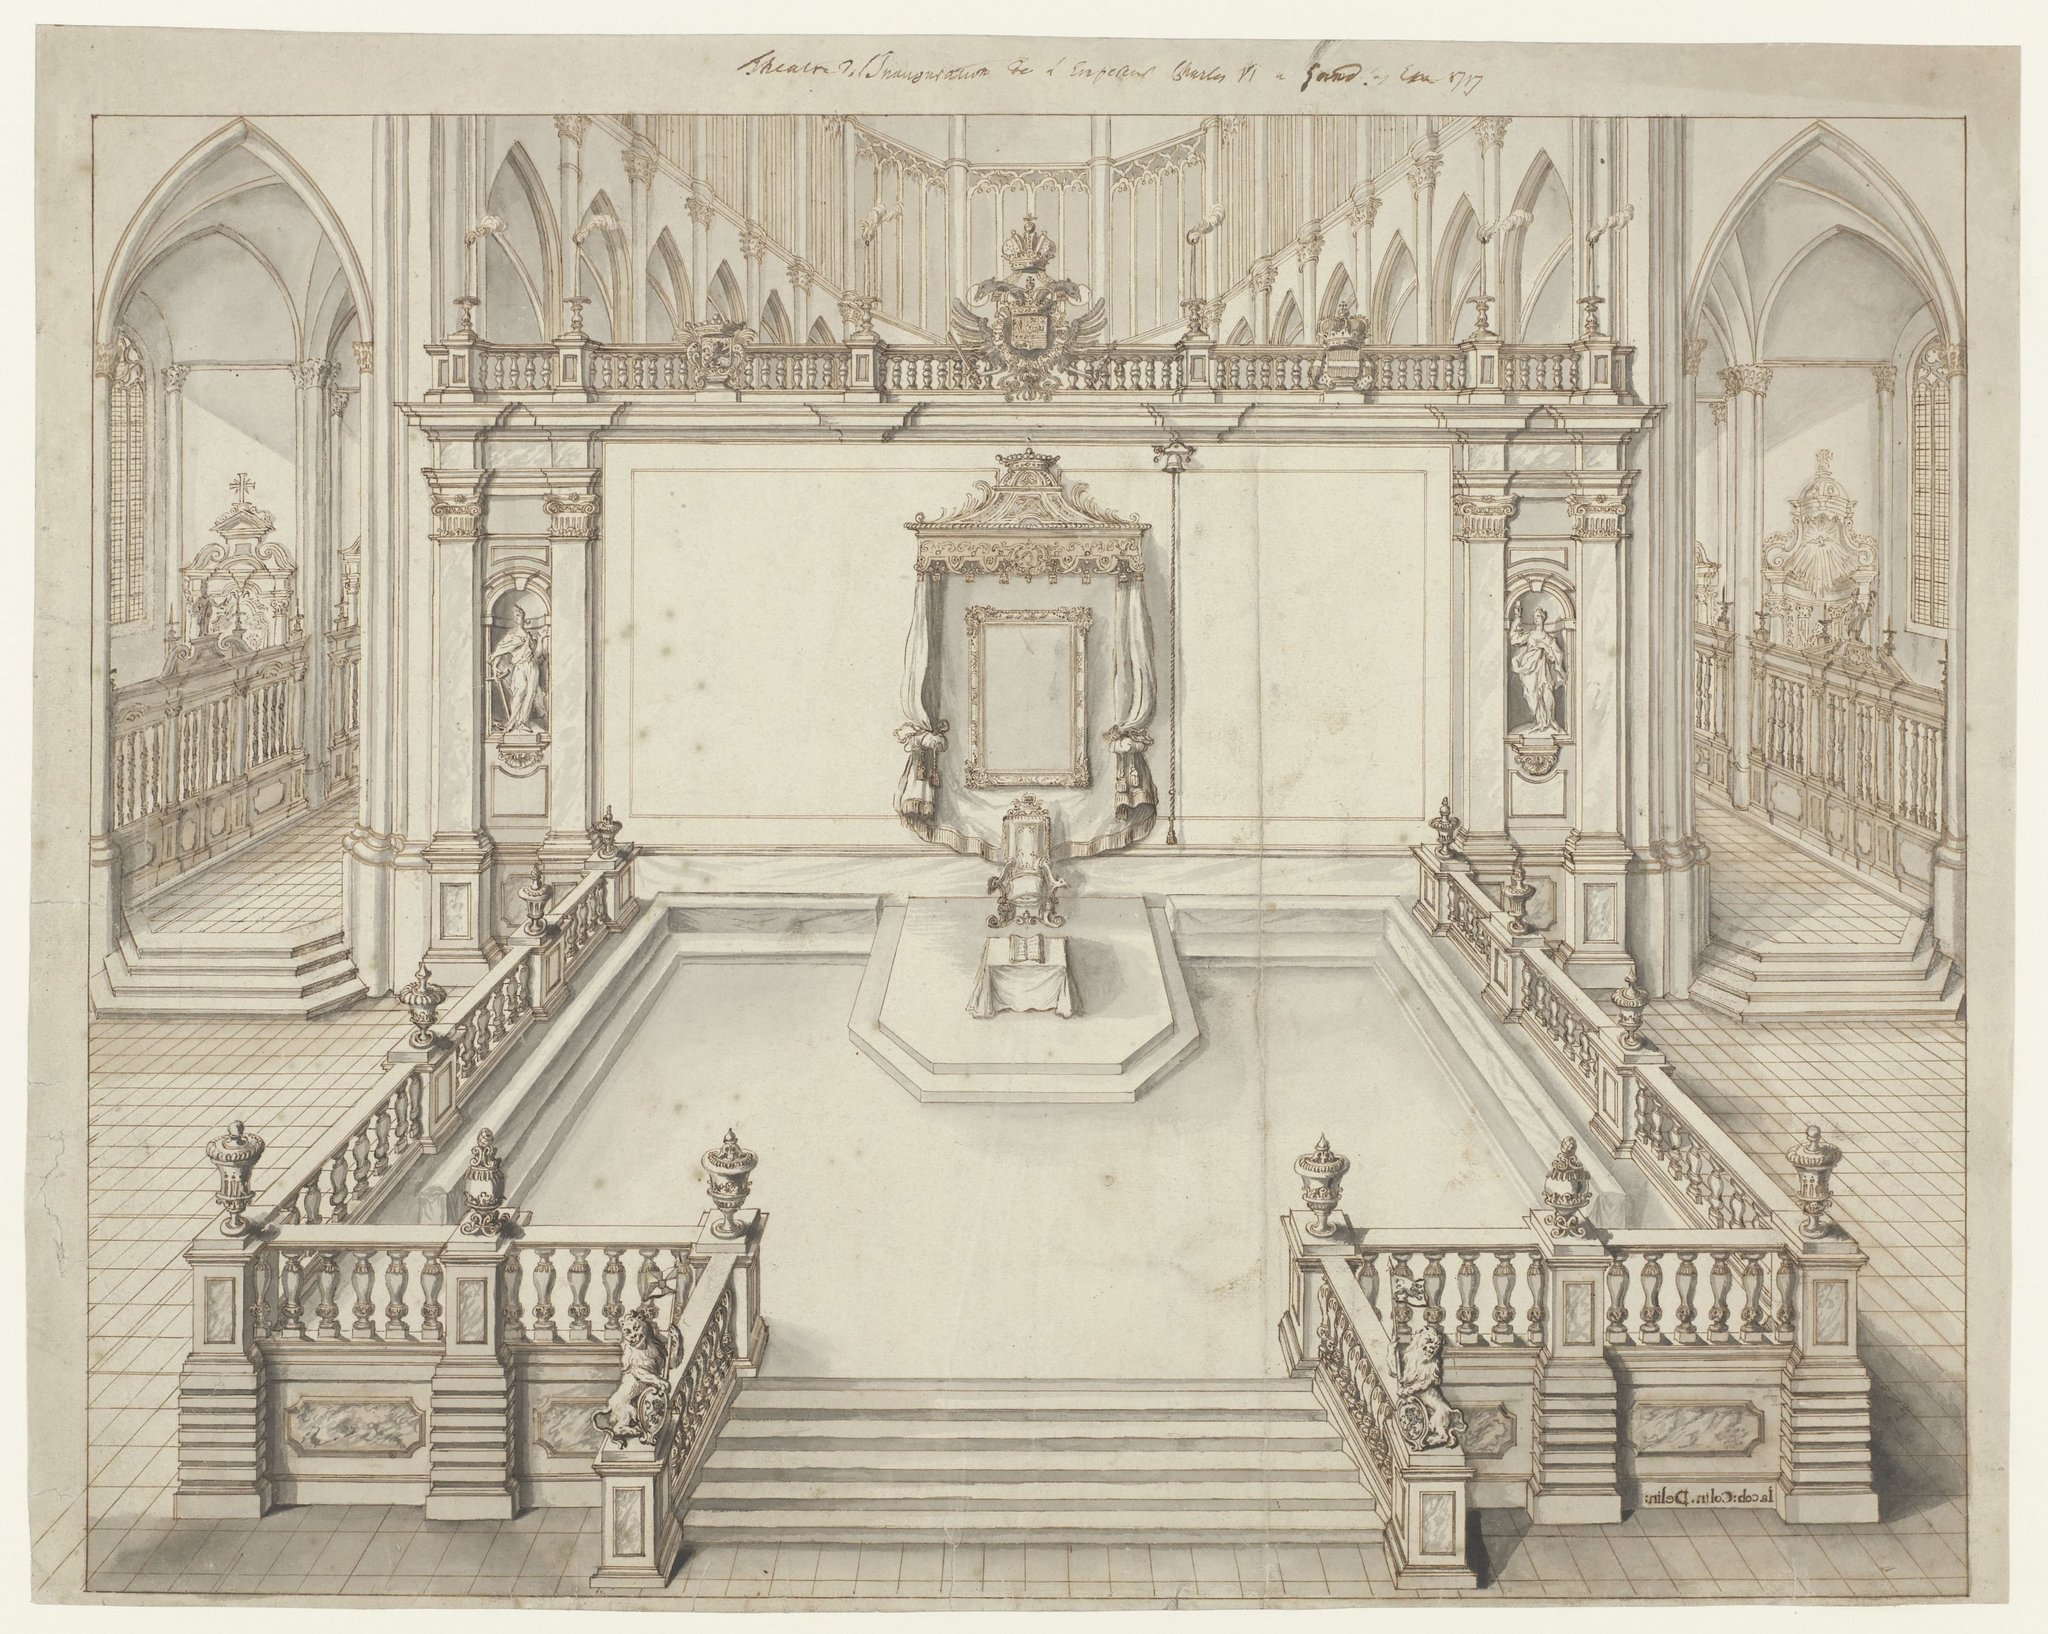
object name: drawing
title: Troonzaal in de Sint-Bavokerk te Gent voor de inhuldiging van keizer Karel VI in 1717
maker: jacob colin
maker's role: draughtsman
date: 1717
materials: paper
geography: southern netherlands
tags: charles vi (holy roman emperor), interior of church, installation of a ruler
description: Gezicht in de troonzaal in de St.-Bavokerk te Gent voor de inhuldiging van aartshertog Karel van Oostenrijk als Karel VI, Duits keizer, in 11 oktober 1717.